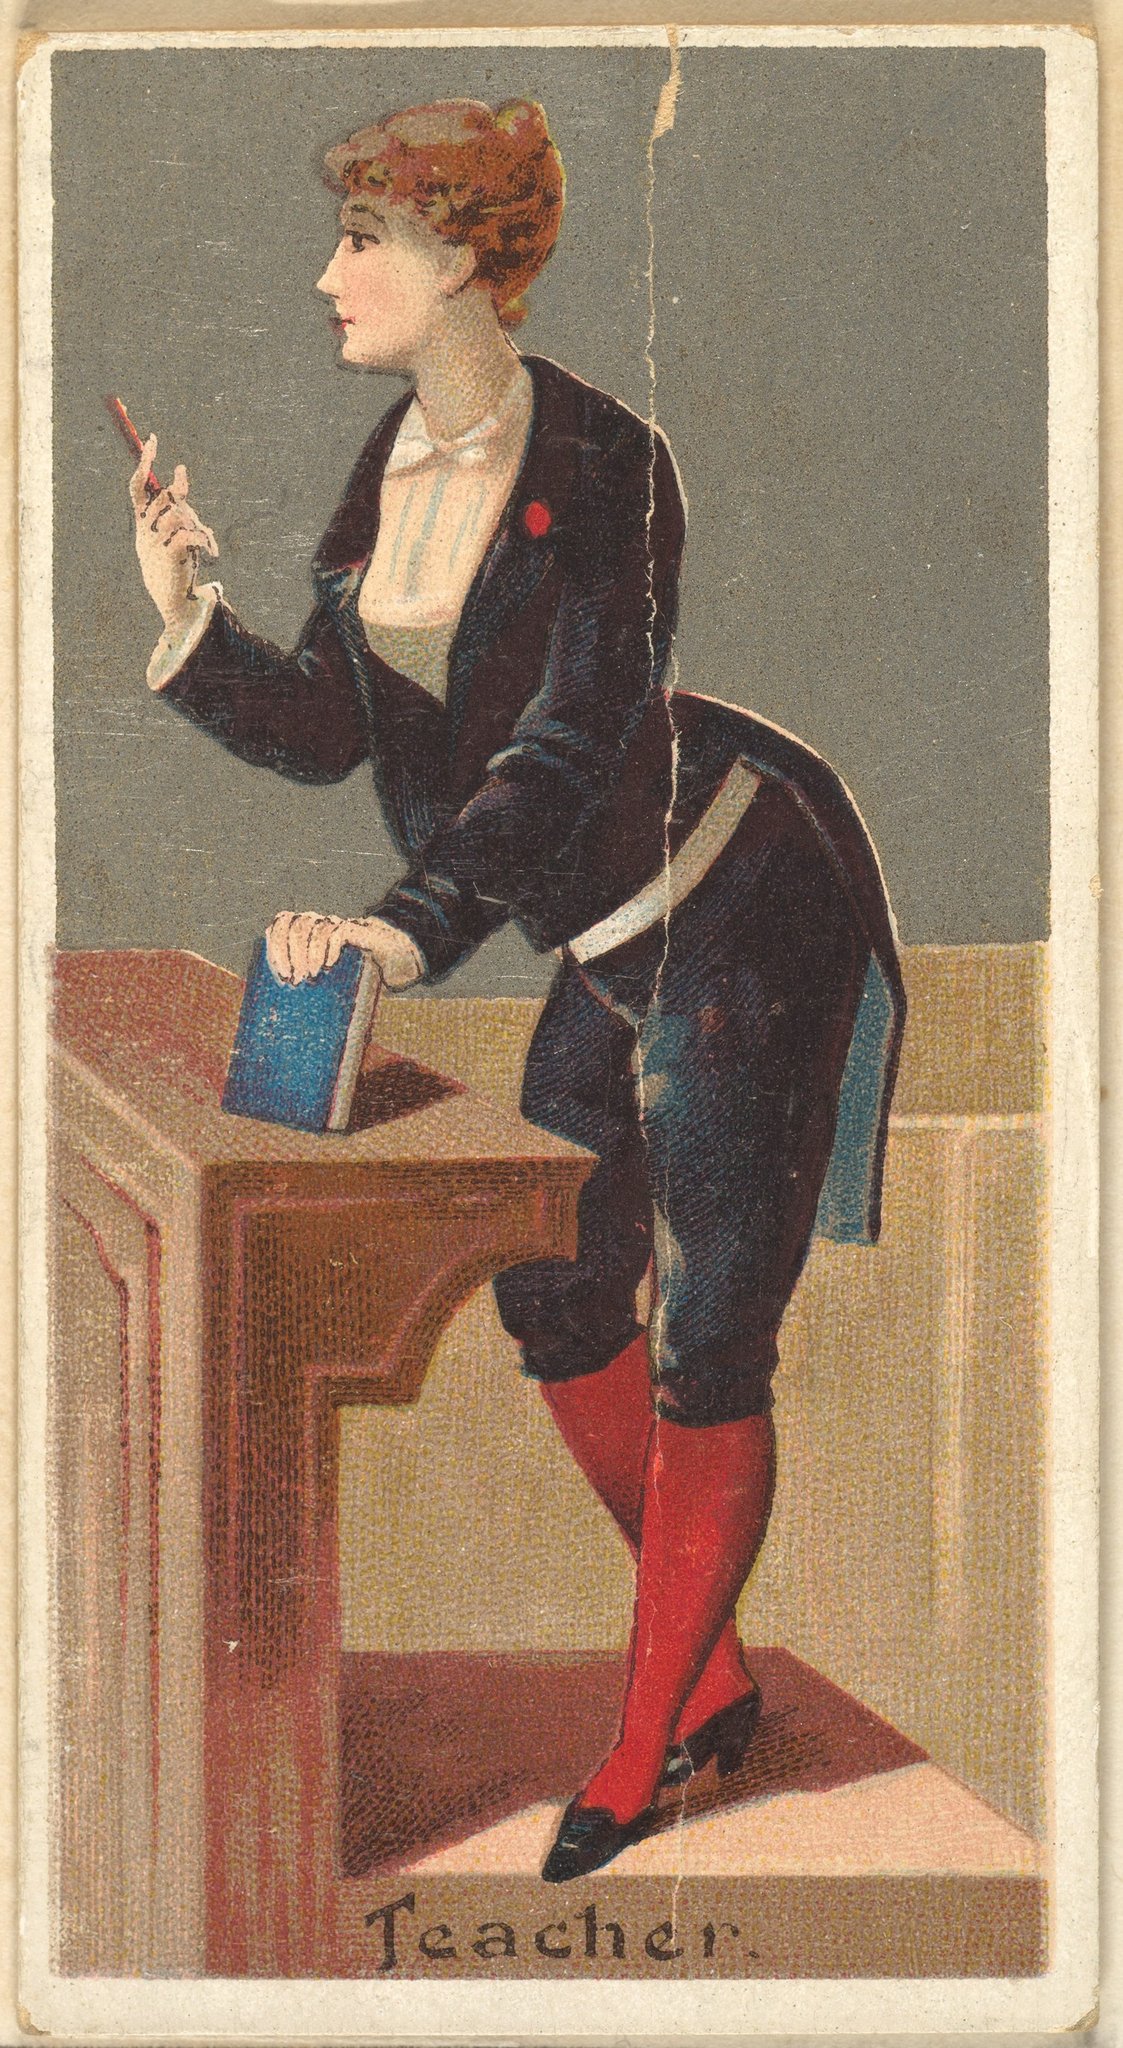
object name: print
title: Teacher, from the Occupations for Women series (N166) for Old Judge and Dogs Head Cigarettes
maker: goodwin & company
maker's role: publisher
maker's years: 1850-1950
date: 1887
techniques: color lithograph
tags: books,profiles,women,teachers